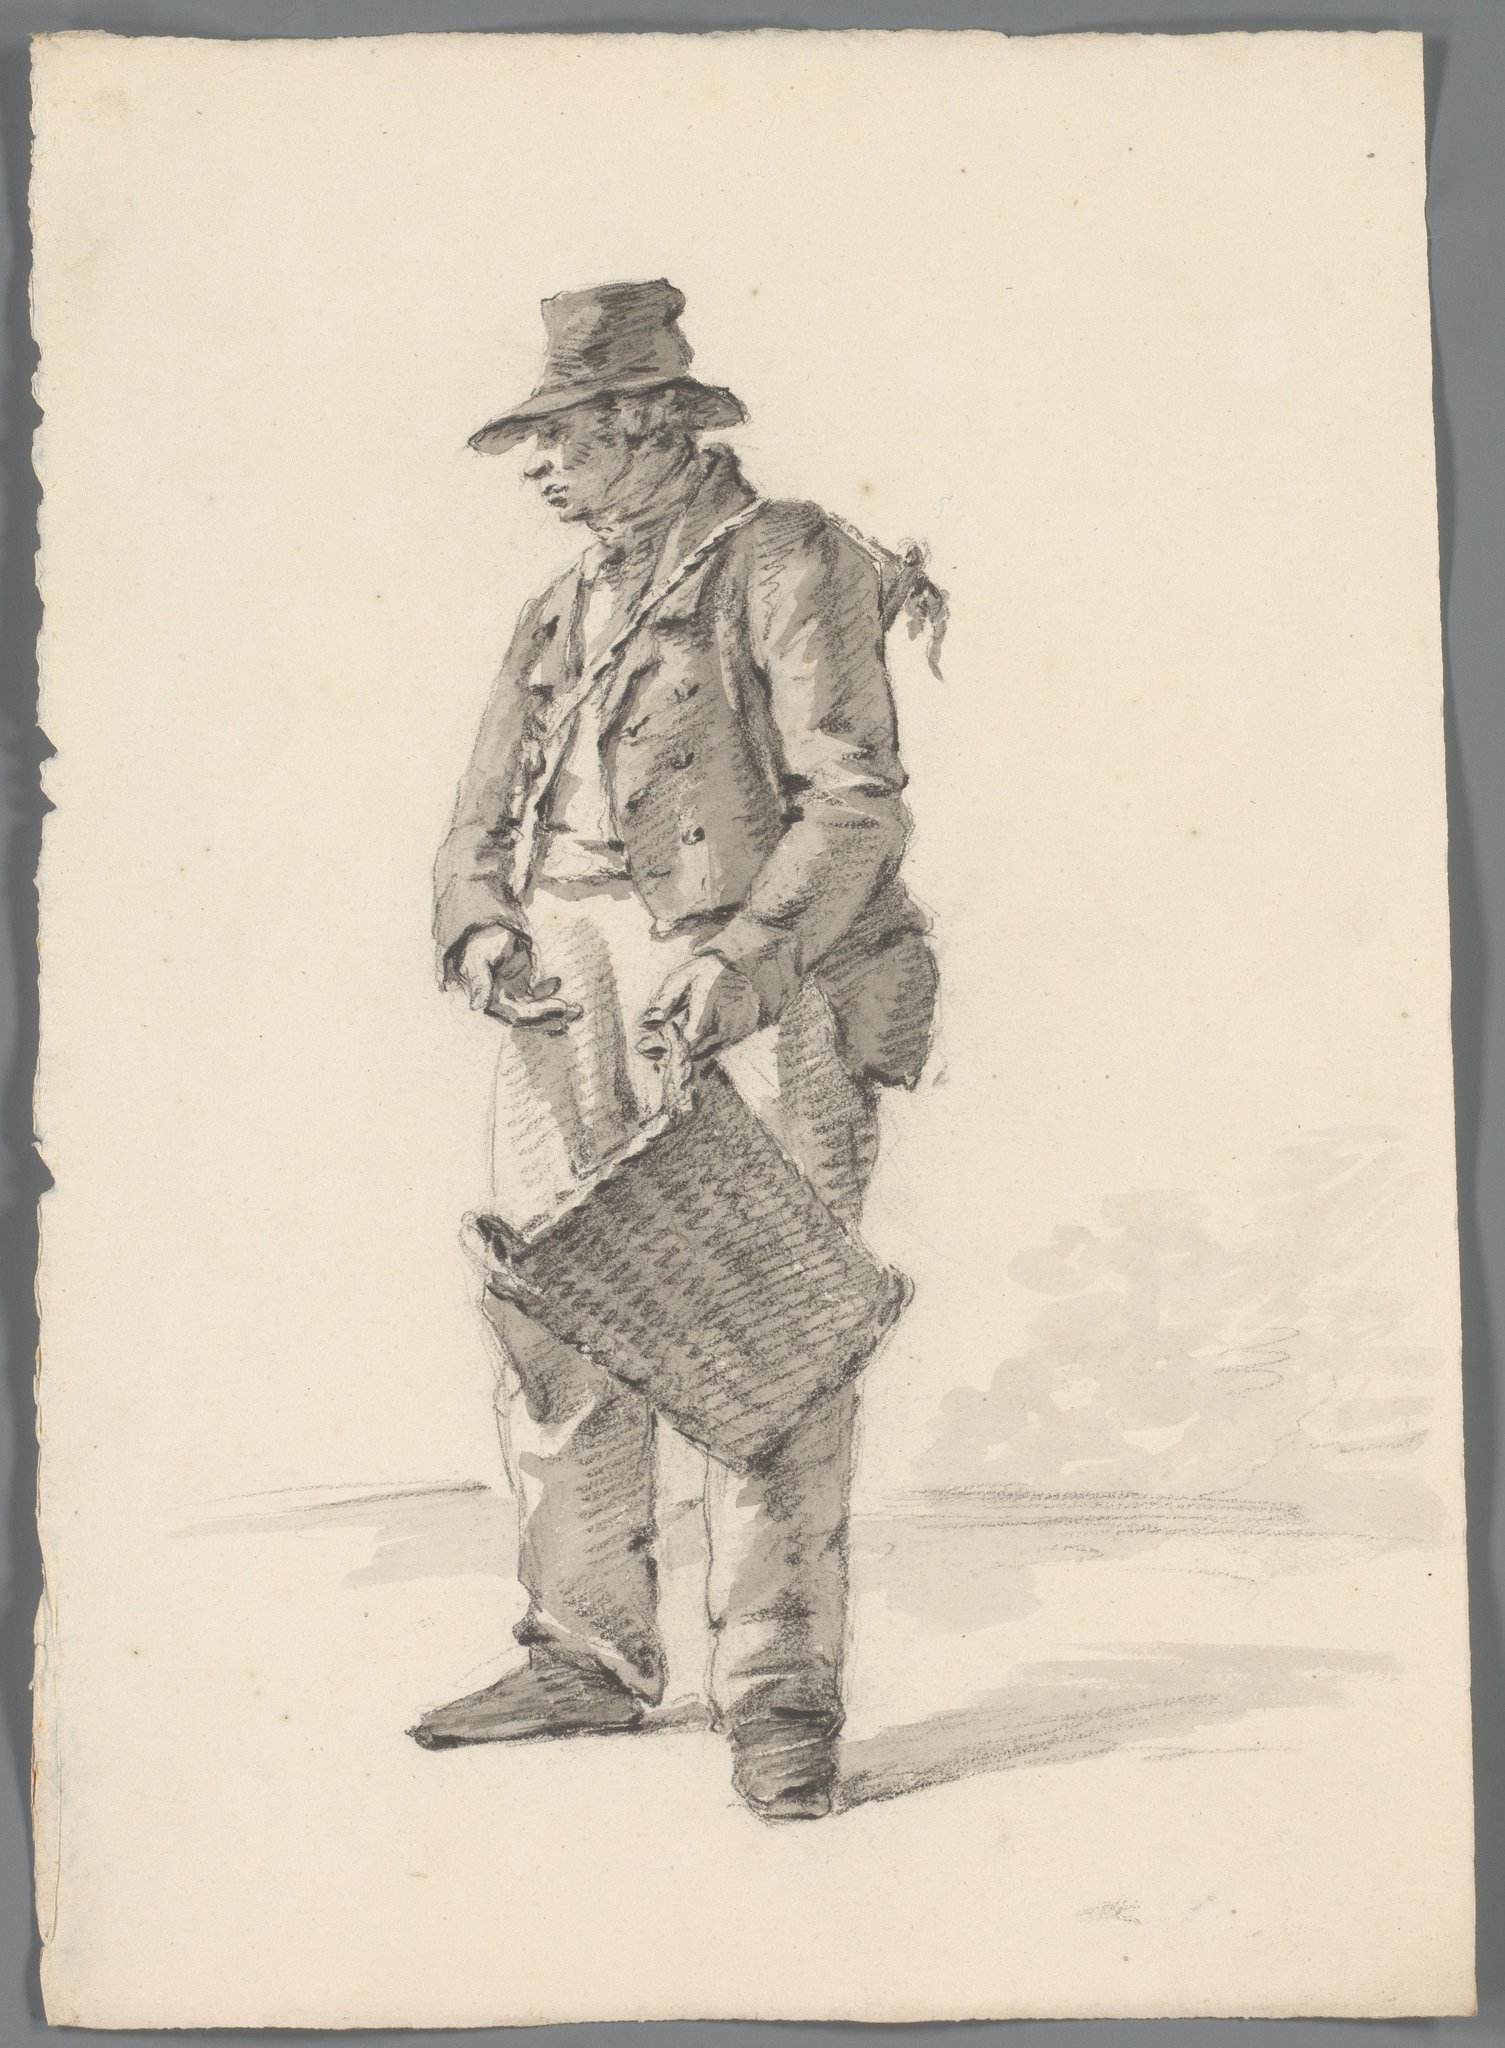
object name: drawing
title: Man met mand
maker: Anonymous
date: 1820-1830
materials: chalk, paper, watercolor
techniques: brush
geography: the hague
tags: adult man, container made of plant material other than wood: basket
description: Tekeningen waarschijnlijk ontstaan bij het Haagse kunstgenootschap ‘Tot Nut der Tekenkunst’, waar twee keer per week tekenavonden werden georganiseerd met geklede modellen.